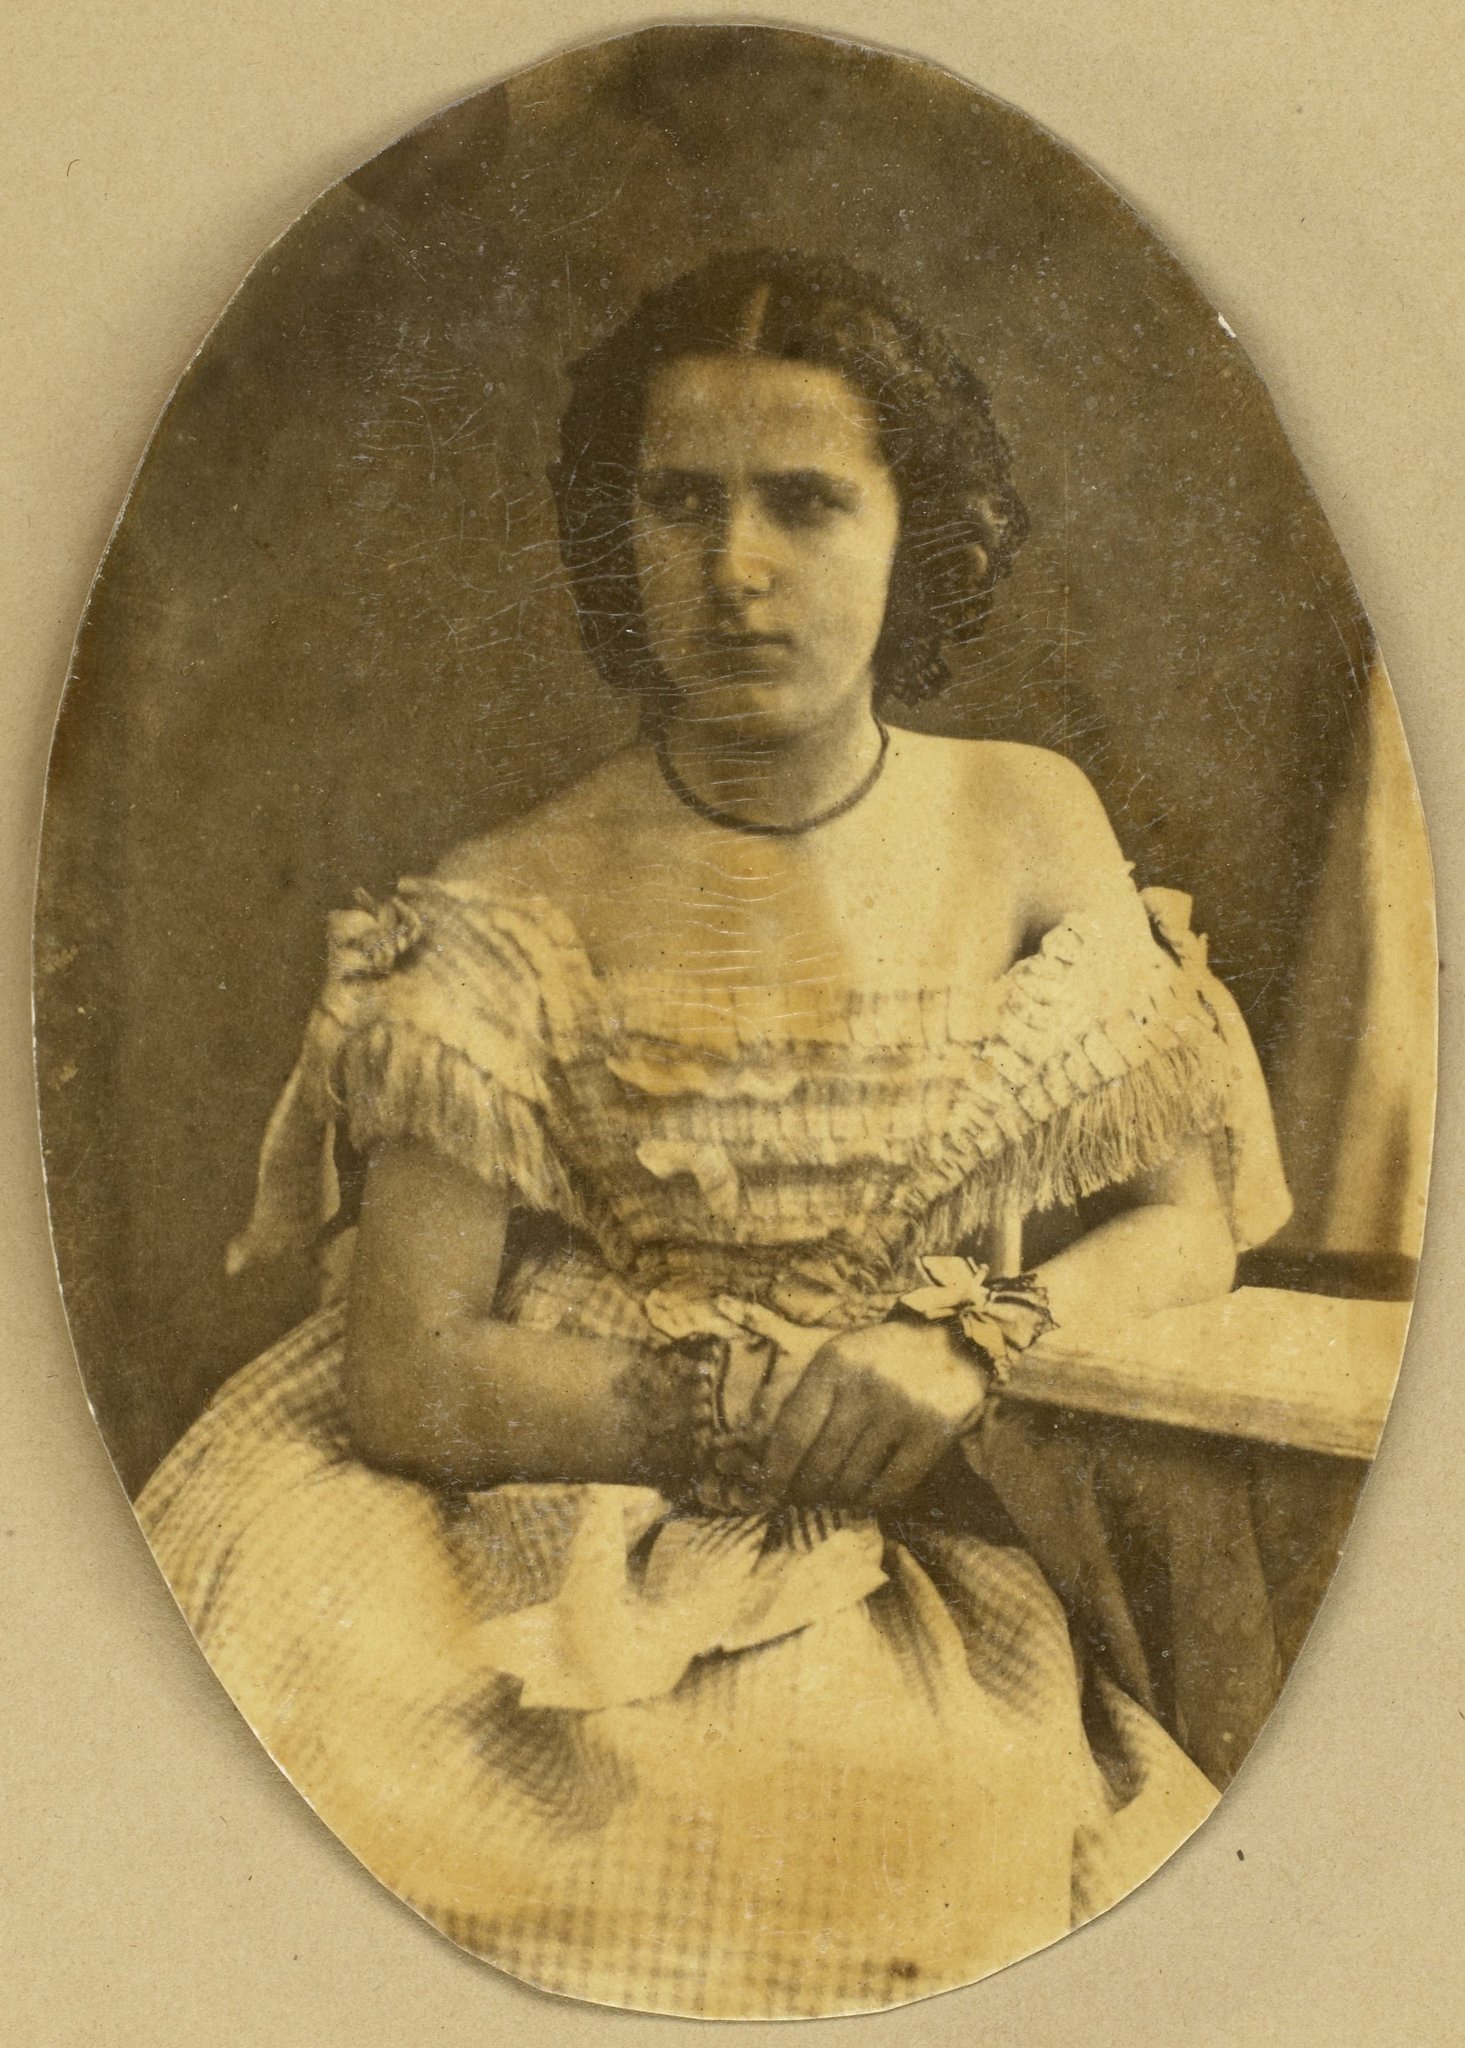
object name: photograph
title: Portret van Anna-Gratia Asser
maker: eduard isaac asser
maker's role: amateurfotograaf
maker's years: 1809-1894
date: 1854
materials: cardboard, paper, photographic support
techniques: salted paper print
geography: amsterdam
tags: historical persons, netherlands